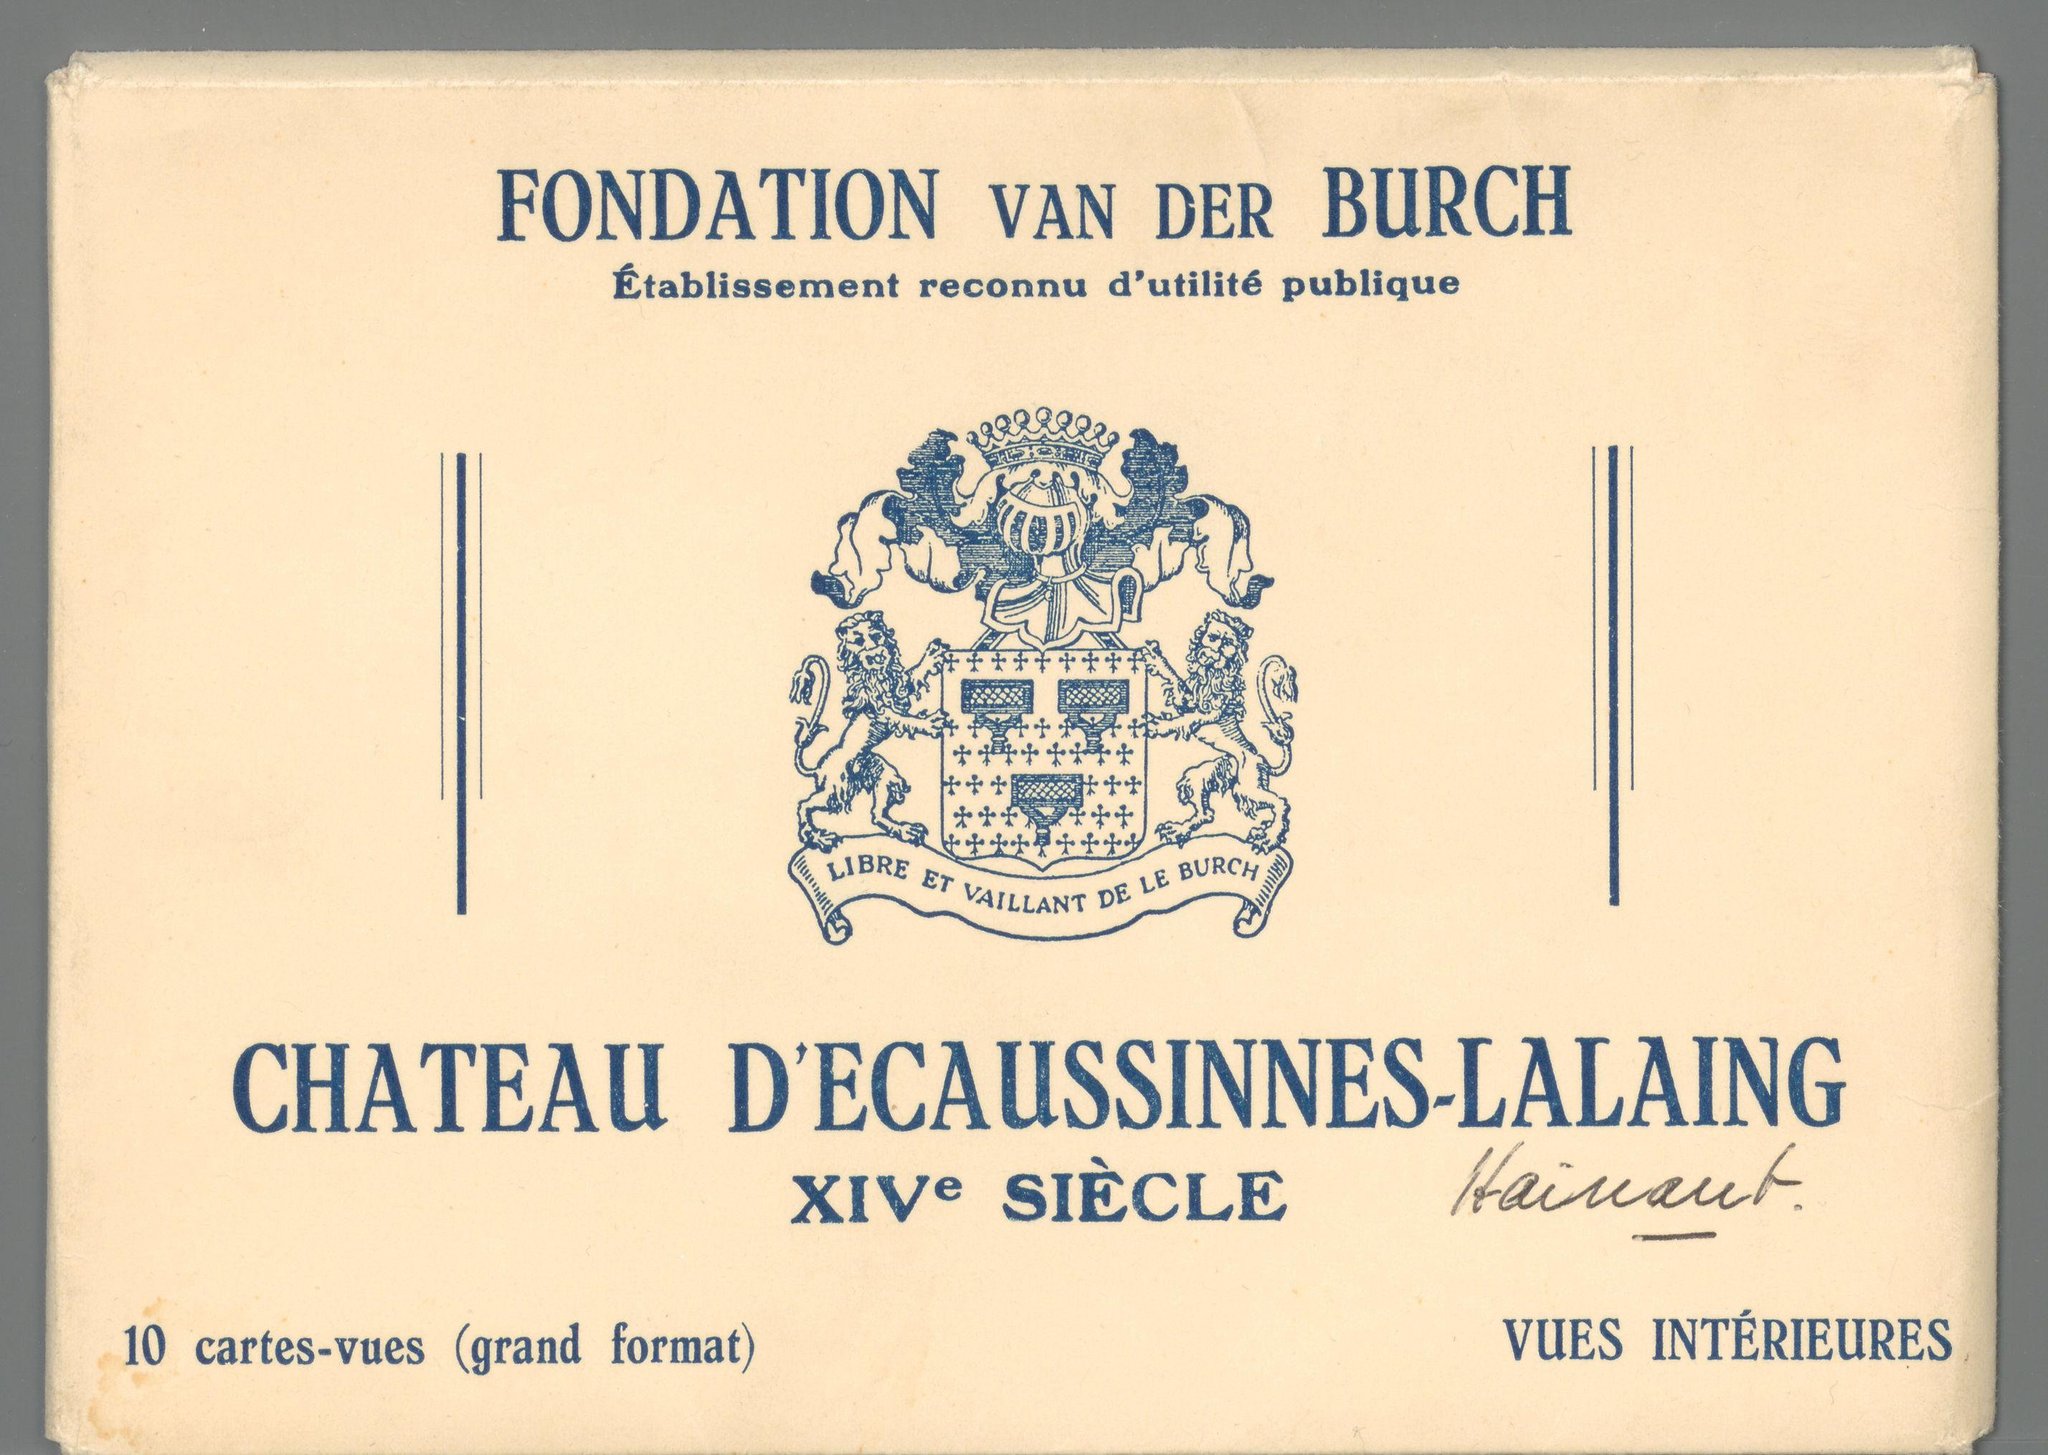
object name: wrapper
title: Chateau d'Ecausinnes-Lalaing, XIVe siècle. 10 cartes-vues (grand format). Vues intérieures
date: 1913-1950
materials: cardboard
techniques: letterpress printing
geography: ecaussinnes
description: De titel op het object spreekt van een inhoud van 10 prentbriefkaarten. Er zijn er 8 aangetroffen aan dit omslag in de Rijksmuseumcollectie.